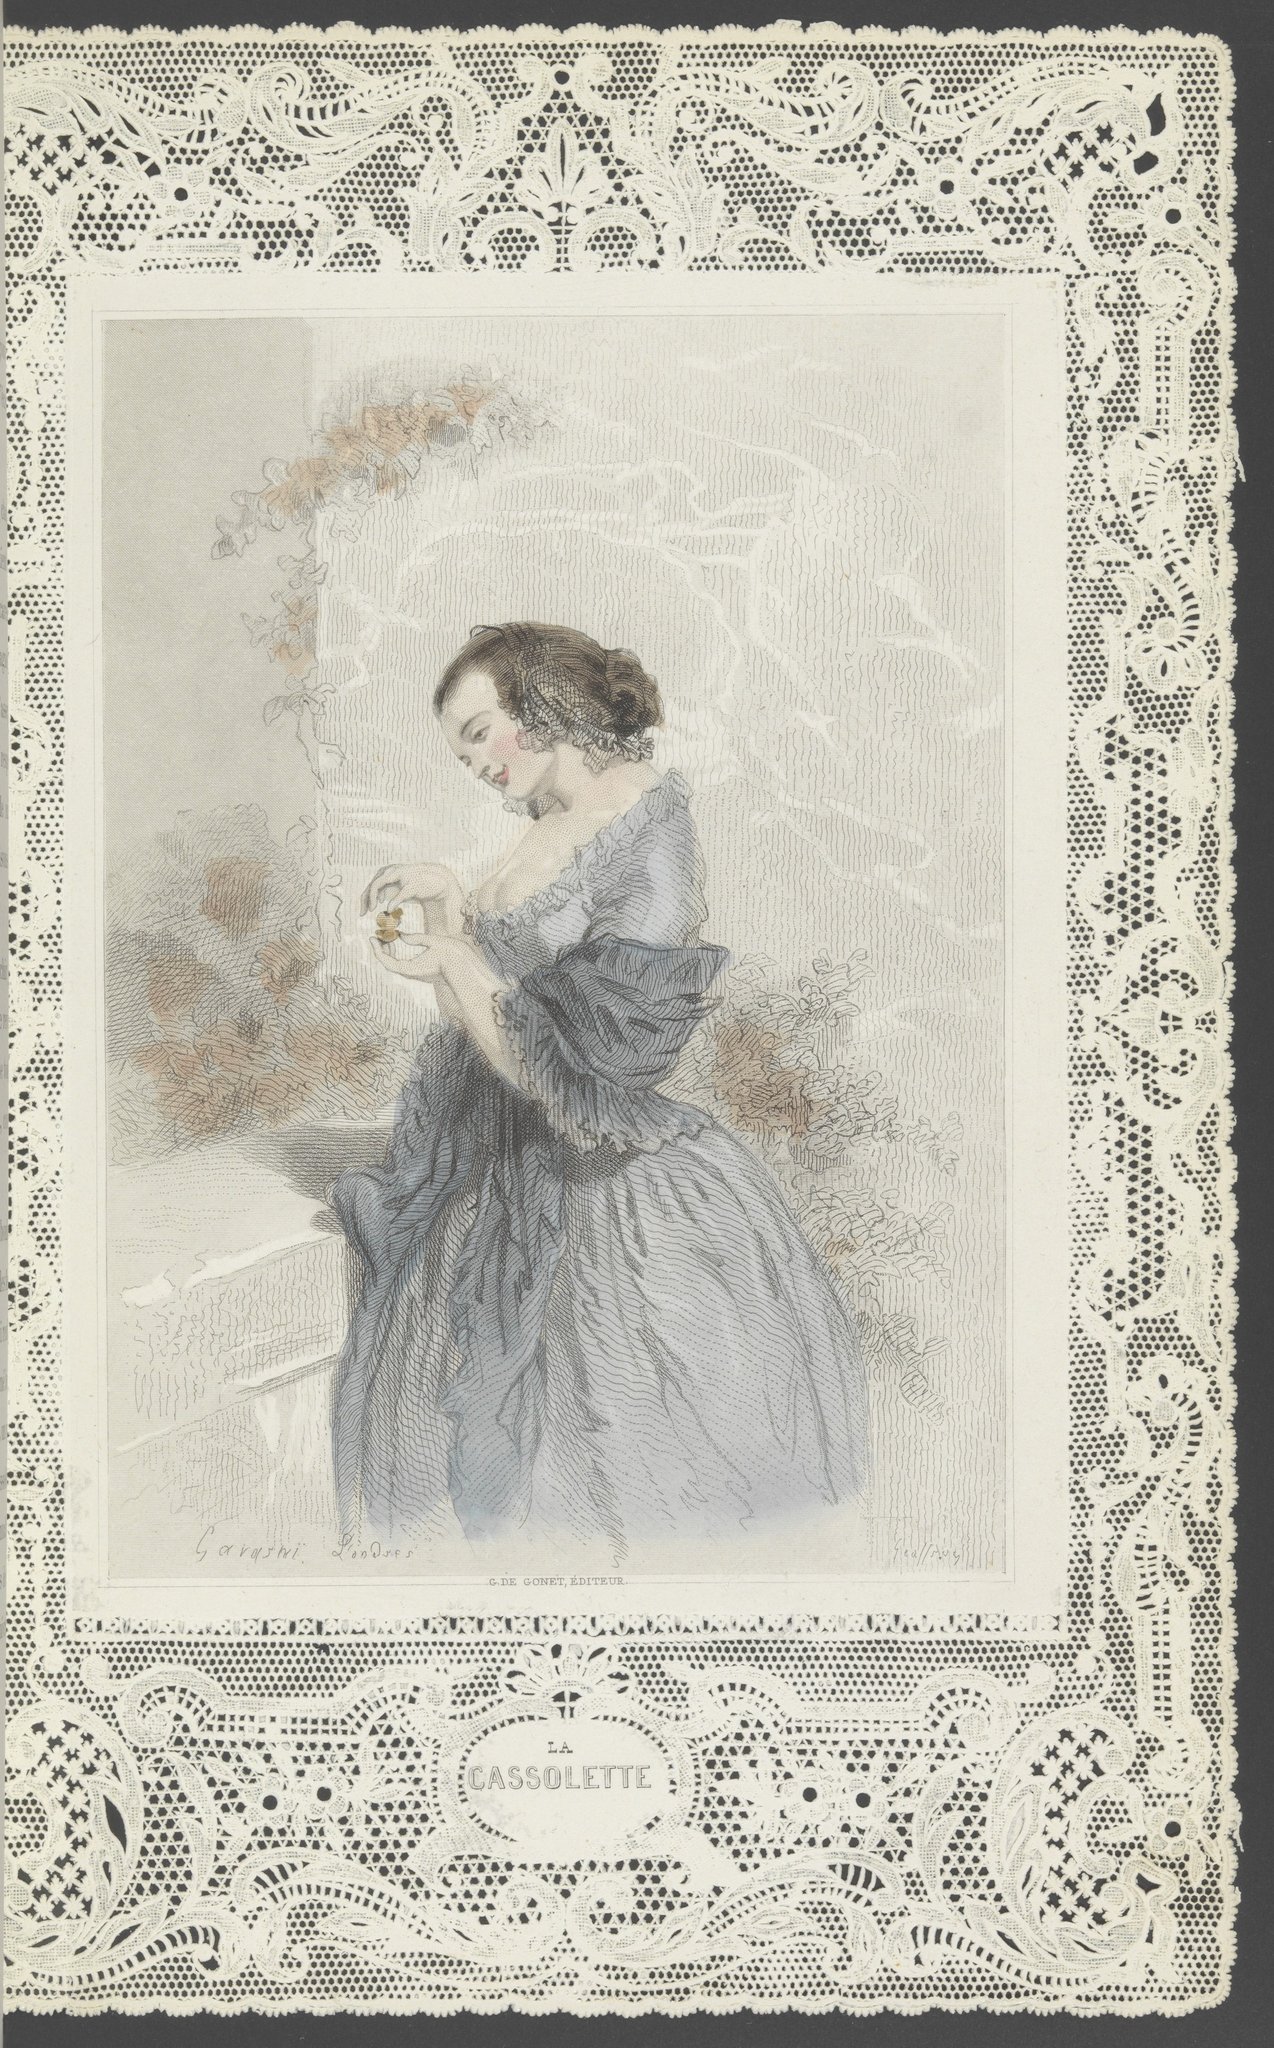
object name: book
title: Perles et Parures, Les Joyaux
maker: v. corbay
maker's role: artist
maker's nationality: french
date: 1850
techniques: etching, hand coloring, engraving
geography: france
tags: women